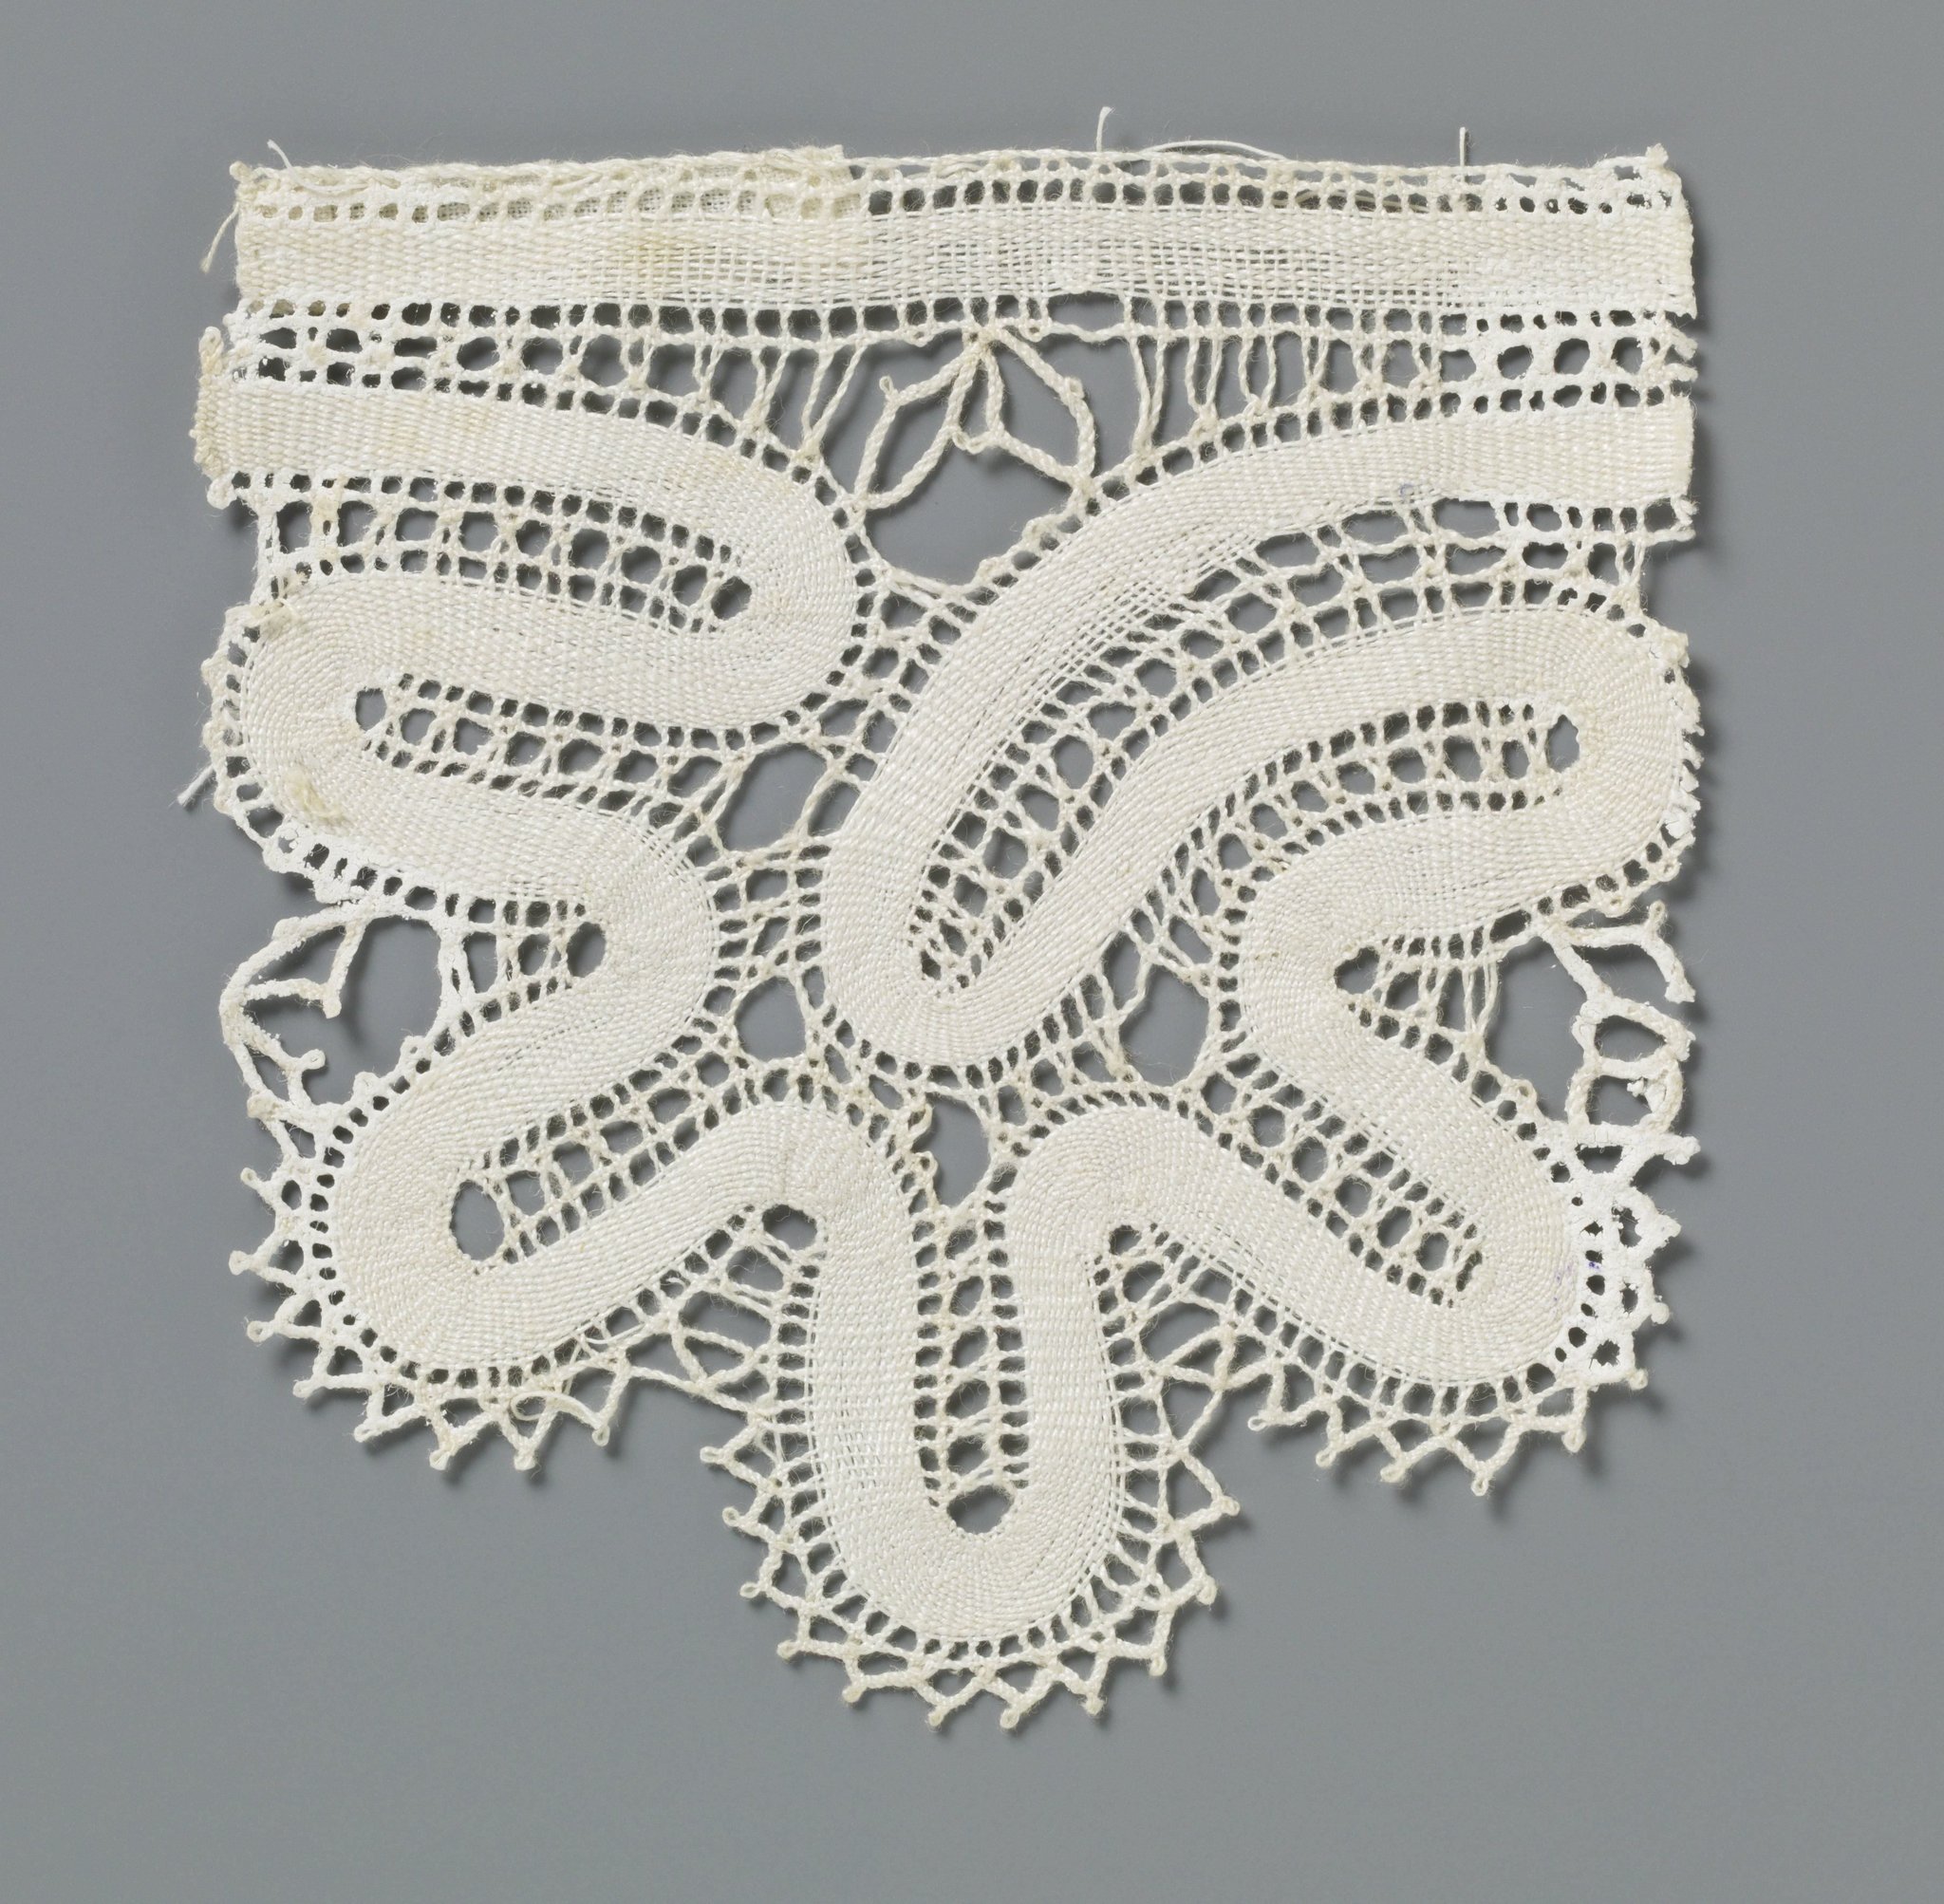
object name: strip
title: Strook kloskant met lobben gevormd door een lint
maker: Anonymous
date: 1900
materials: cotton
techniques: lace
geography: russia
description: Strook naturelkleurige kloskant: Russische kant. Het patroon wordt gevormd door een lint dat al slingerend lobben vormt. Het lint is gemaakt in dichtgewerkte linnenslag, met opengewerkte randen. Het slingerende lint worden door vlechtjes in vorm gehouden. De bovenzijde is recht afgewerkt. De onderste lobben vormen de schulpen en die zijn afgewerkt met driehoekjes gemaakt van vlechtjes, met aan elk puntje een picot.